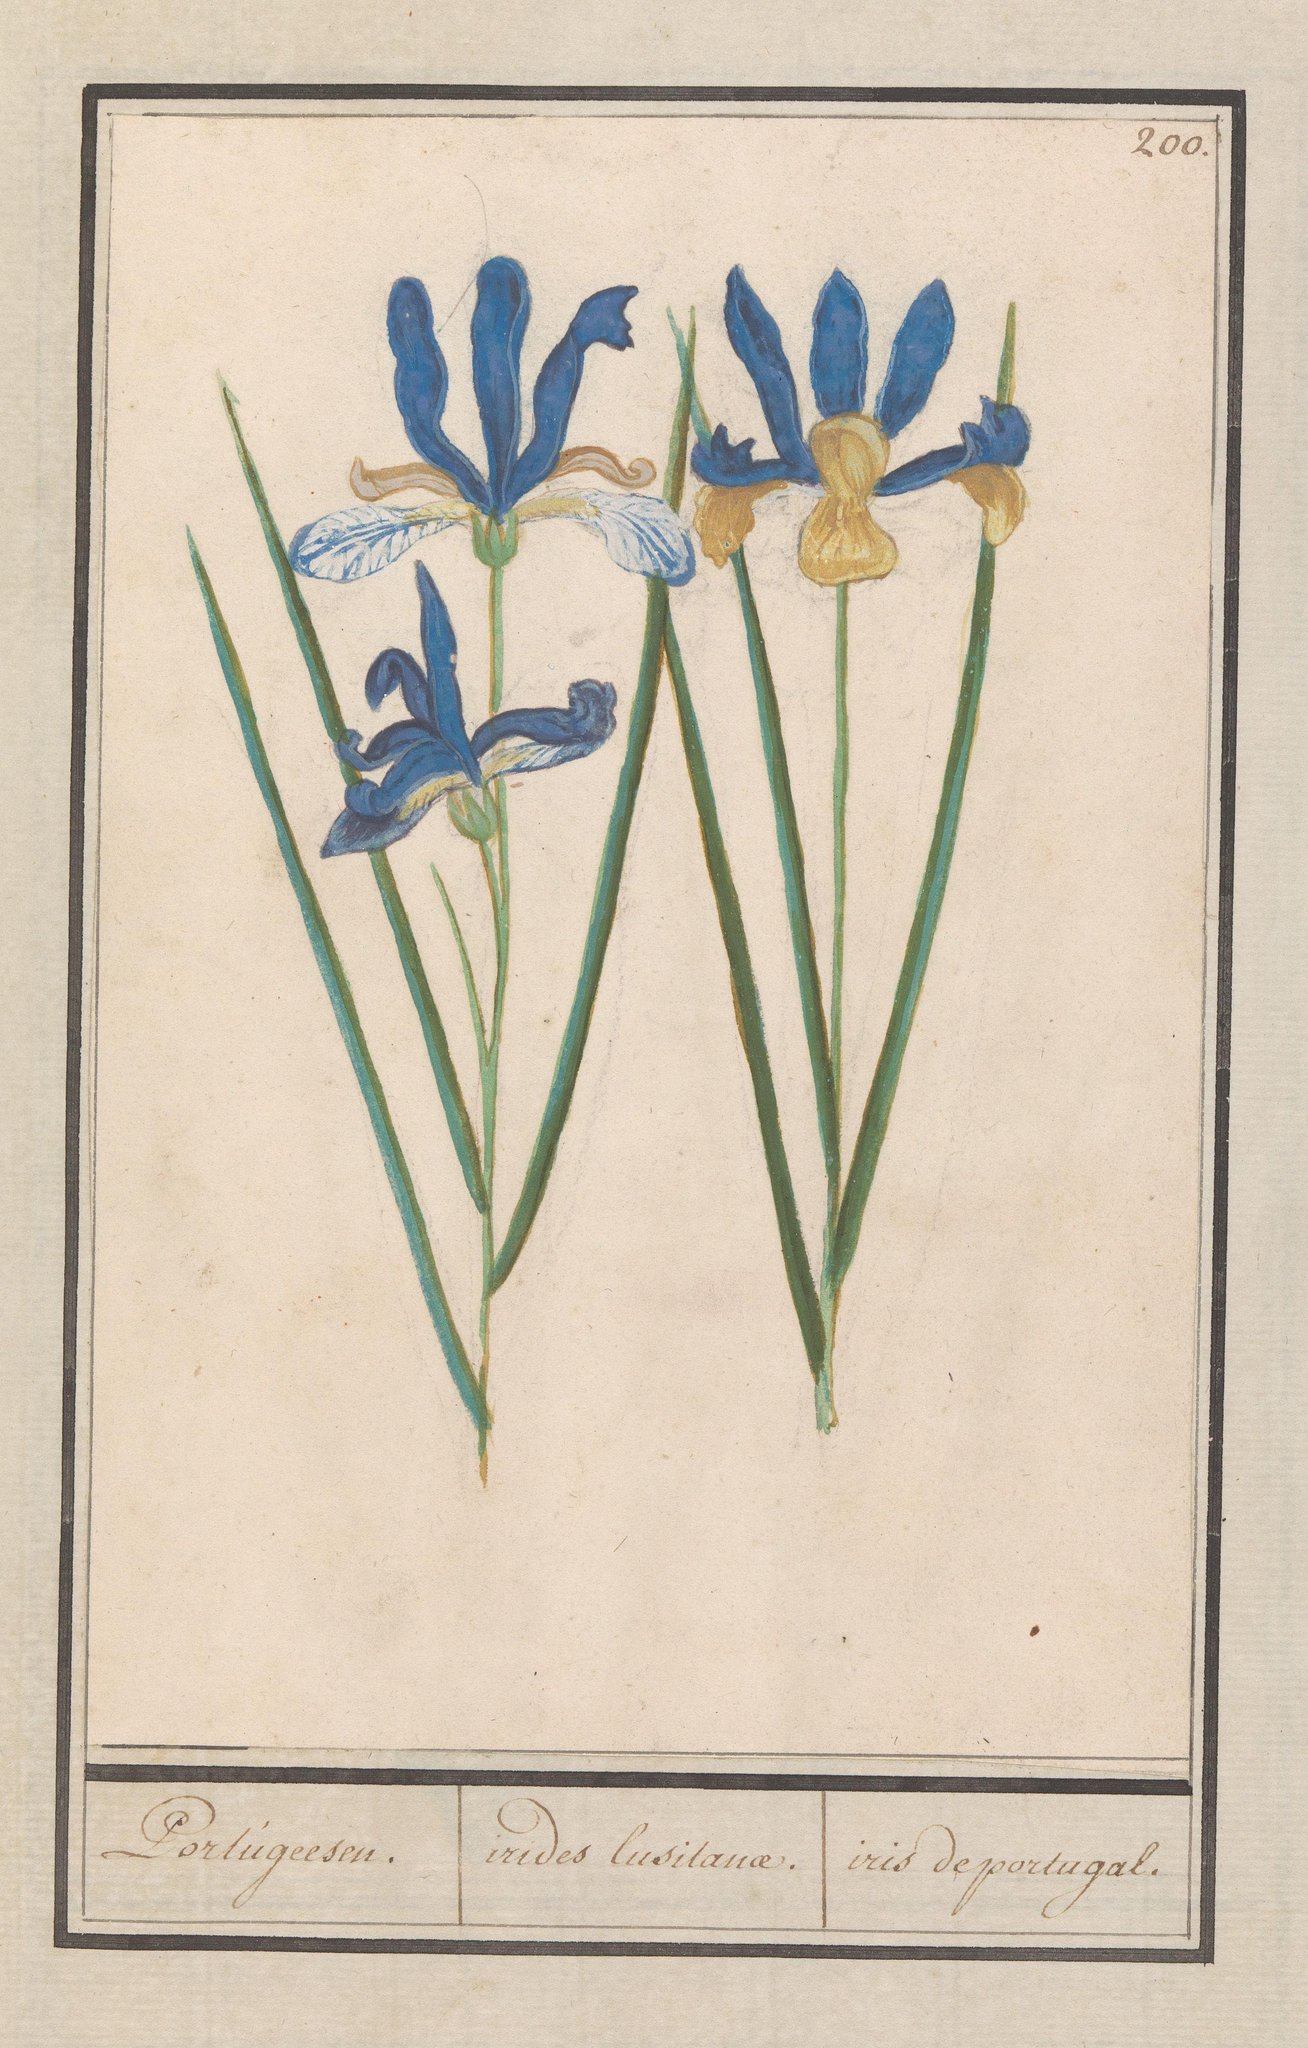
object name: drawing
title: Portugeesen. / irides lusitanae. / iris portugal.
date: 1596-1610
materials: chalk, paint, paper, watercolor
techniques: brush, pen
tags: flowers: iris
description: Blauwe lis. Genummerd rechtsboven: 200. Onderdeel van het derde album met tekeningen van bloemen en planten. Tiende van twaalf albums met tekeningen van dieren, vogels en planten bekend rond 1600, gemaakt in opdracht van keizer Rudolf II. Met toelichting in Nederlands, Latijn en Frans.